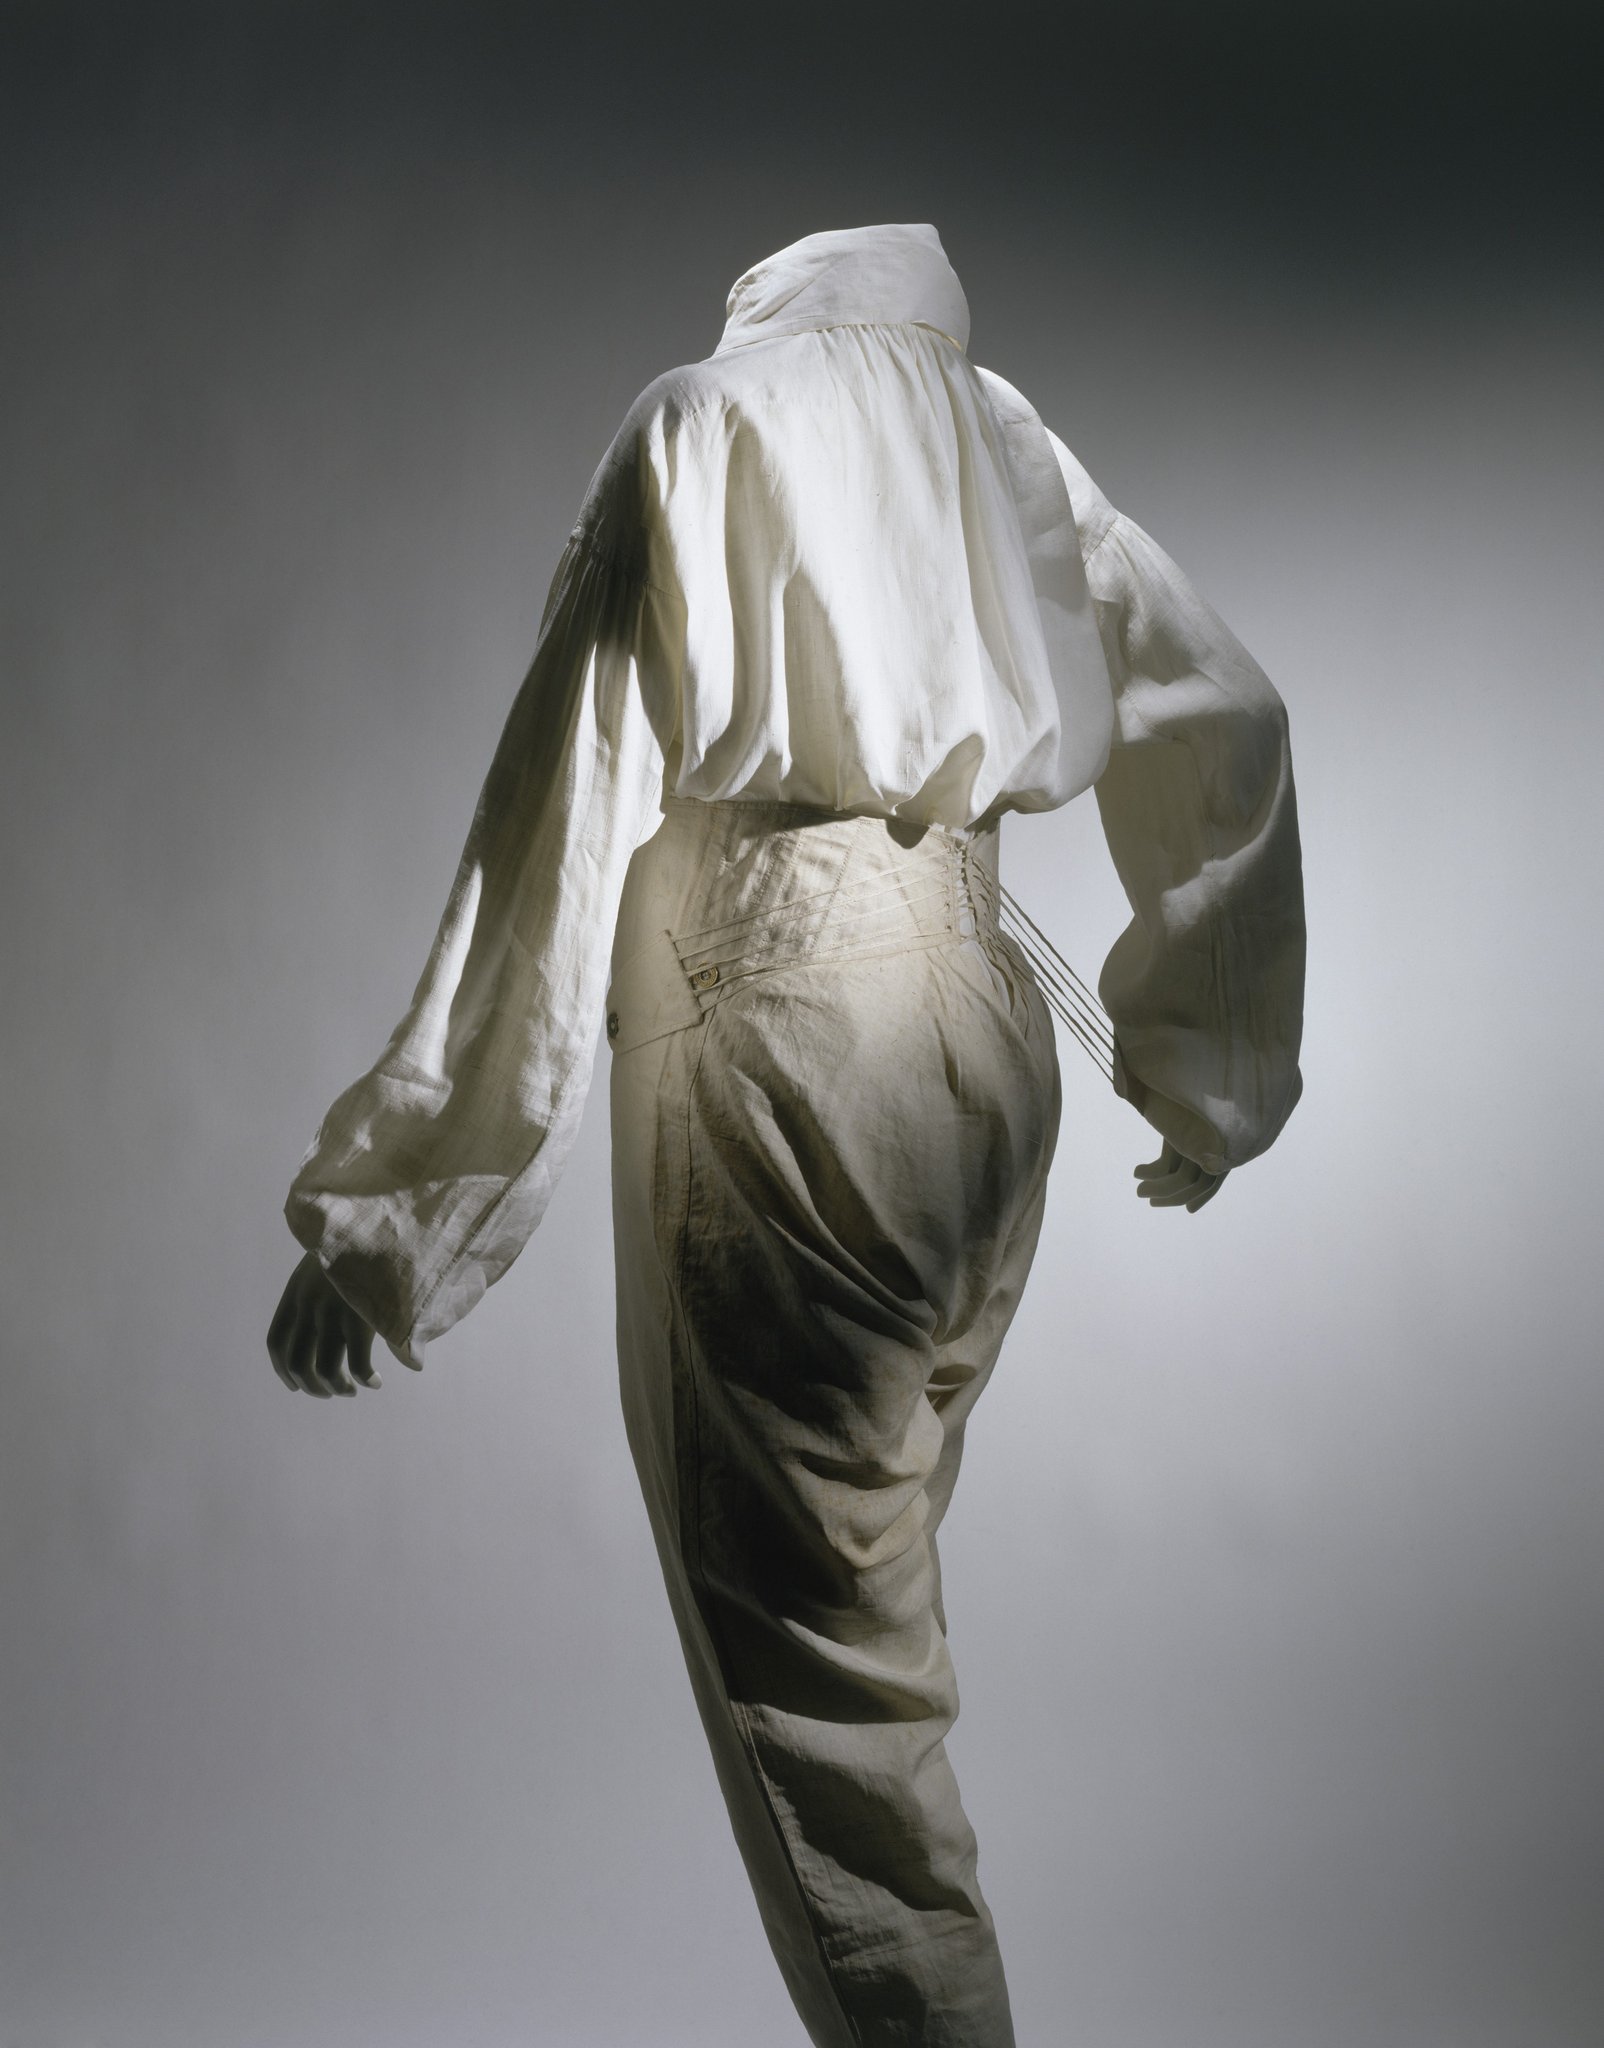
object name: underpants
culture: french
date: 1830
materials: linen